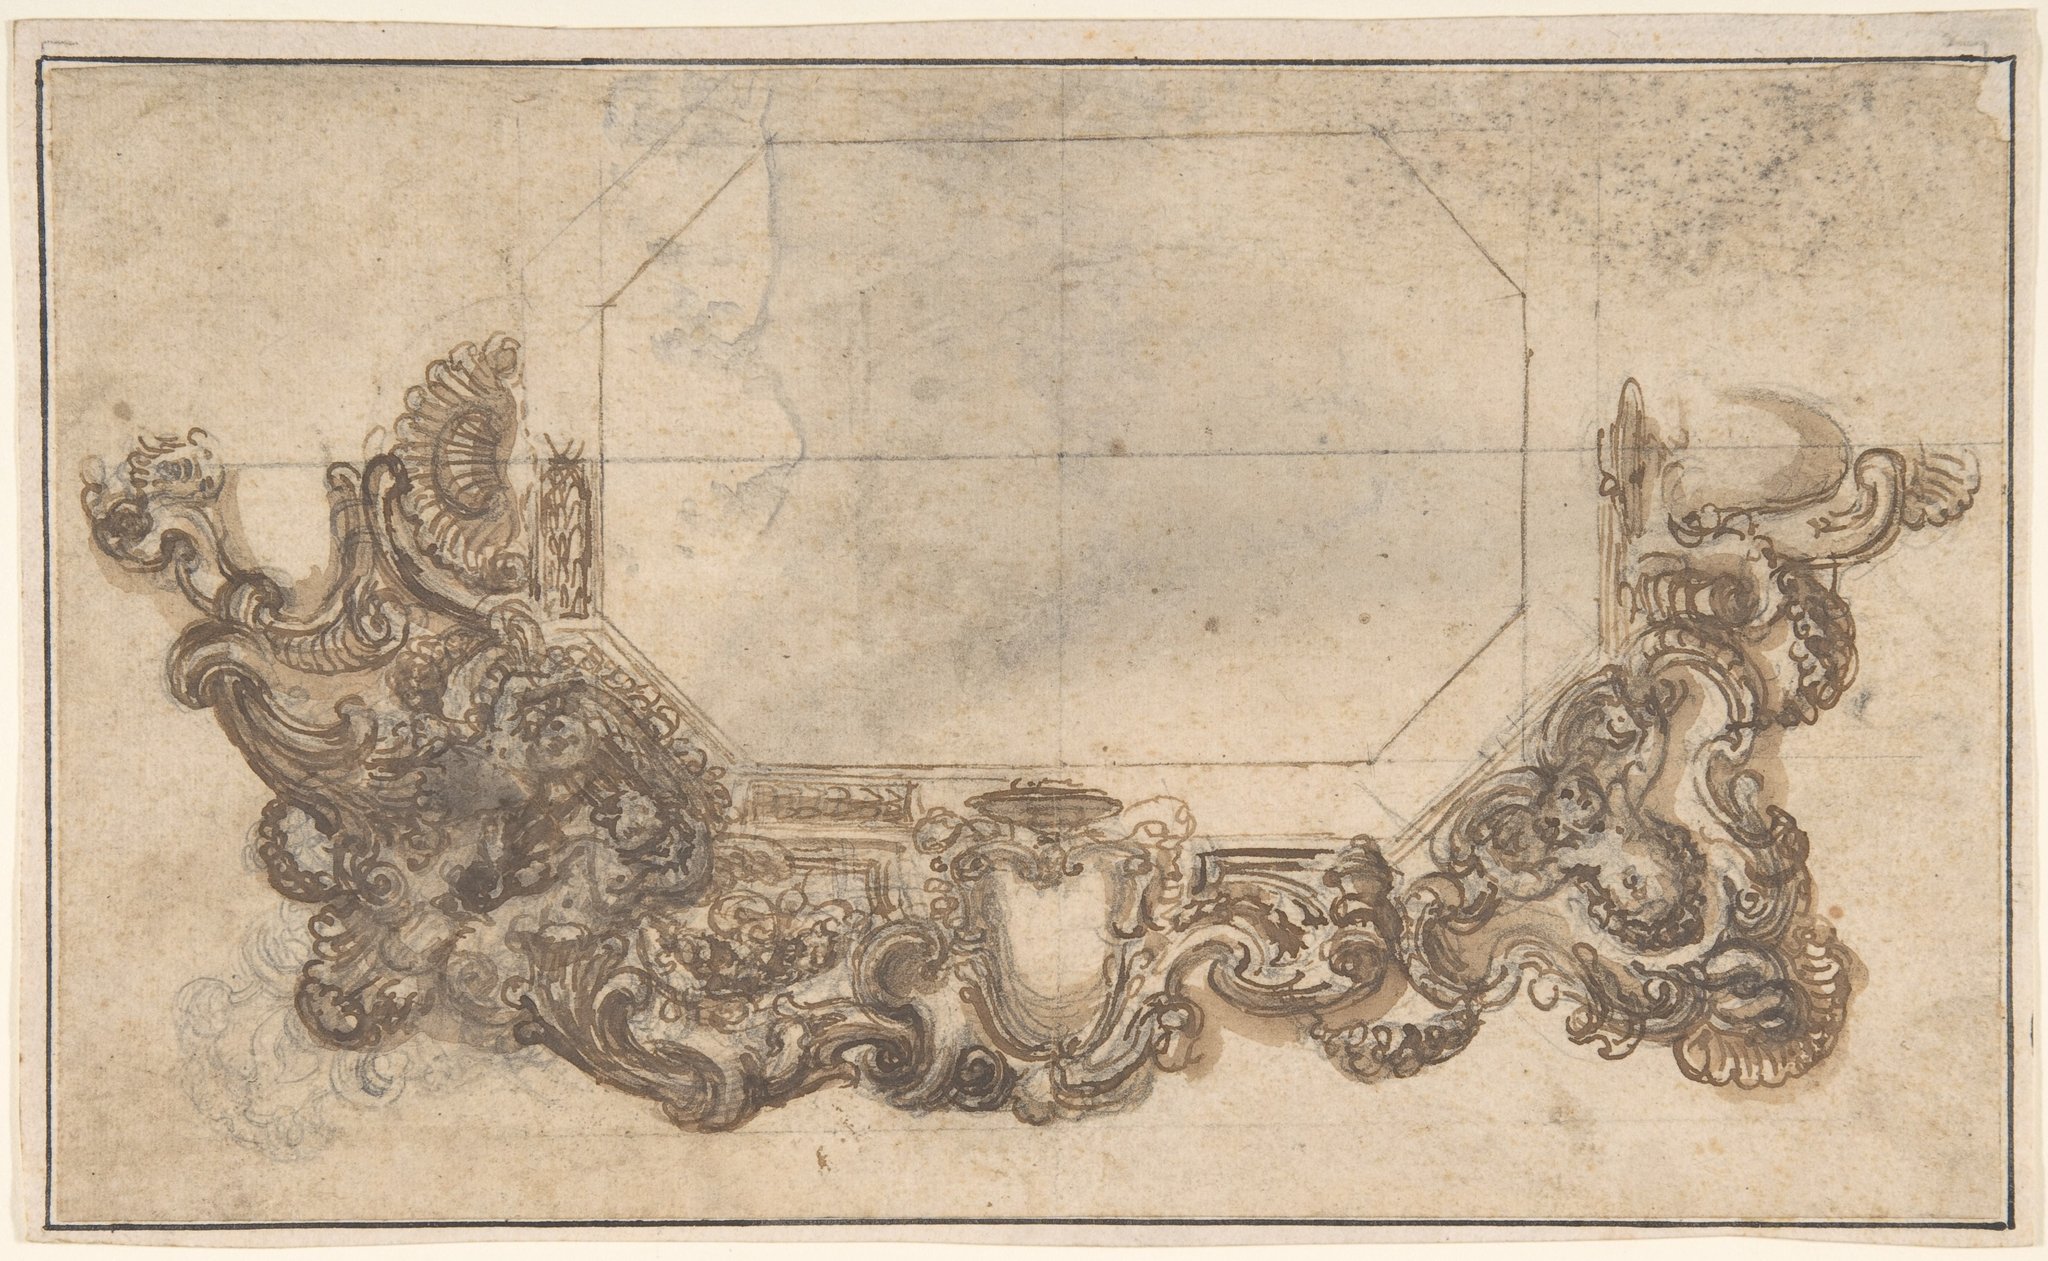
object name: drawing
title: Right Half of Mirror Frame Design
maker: anonymous, italian, 17th century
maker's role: artist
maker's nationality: italian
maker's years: 1600-1700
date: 1601-1700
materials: graphite, ink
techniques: pen, drawing